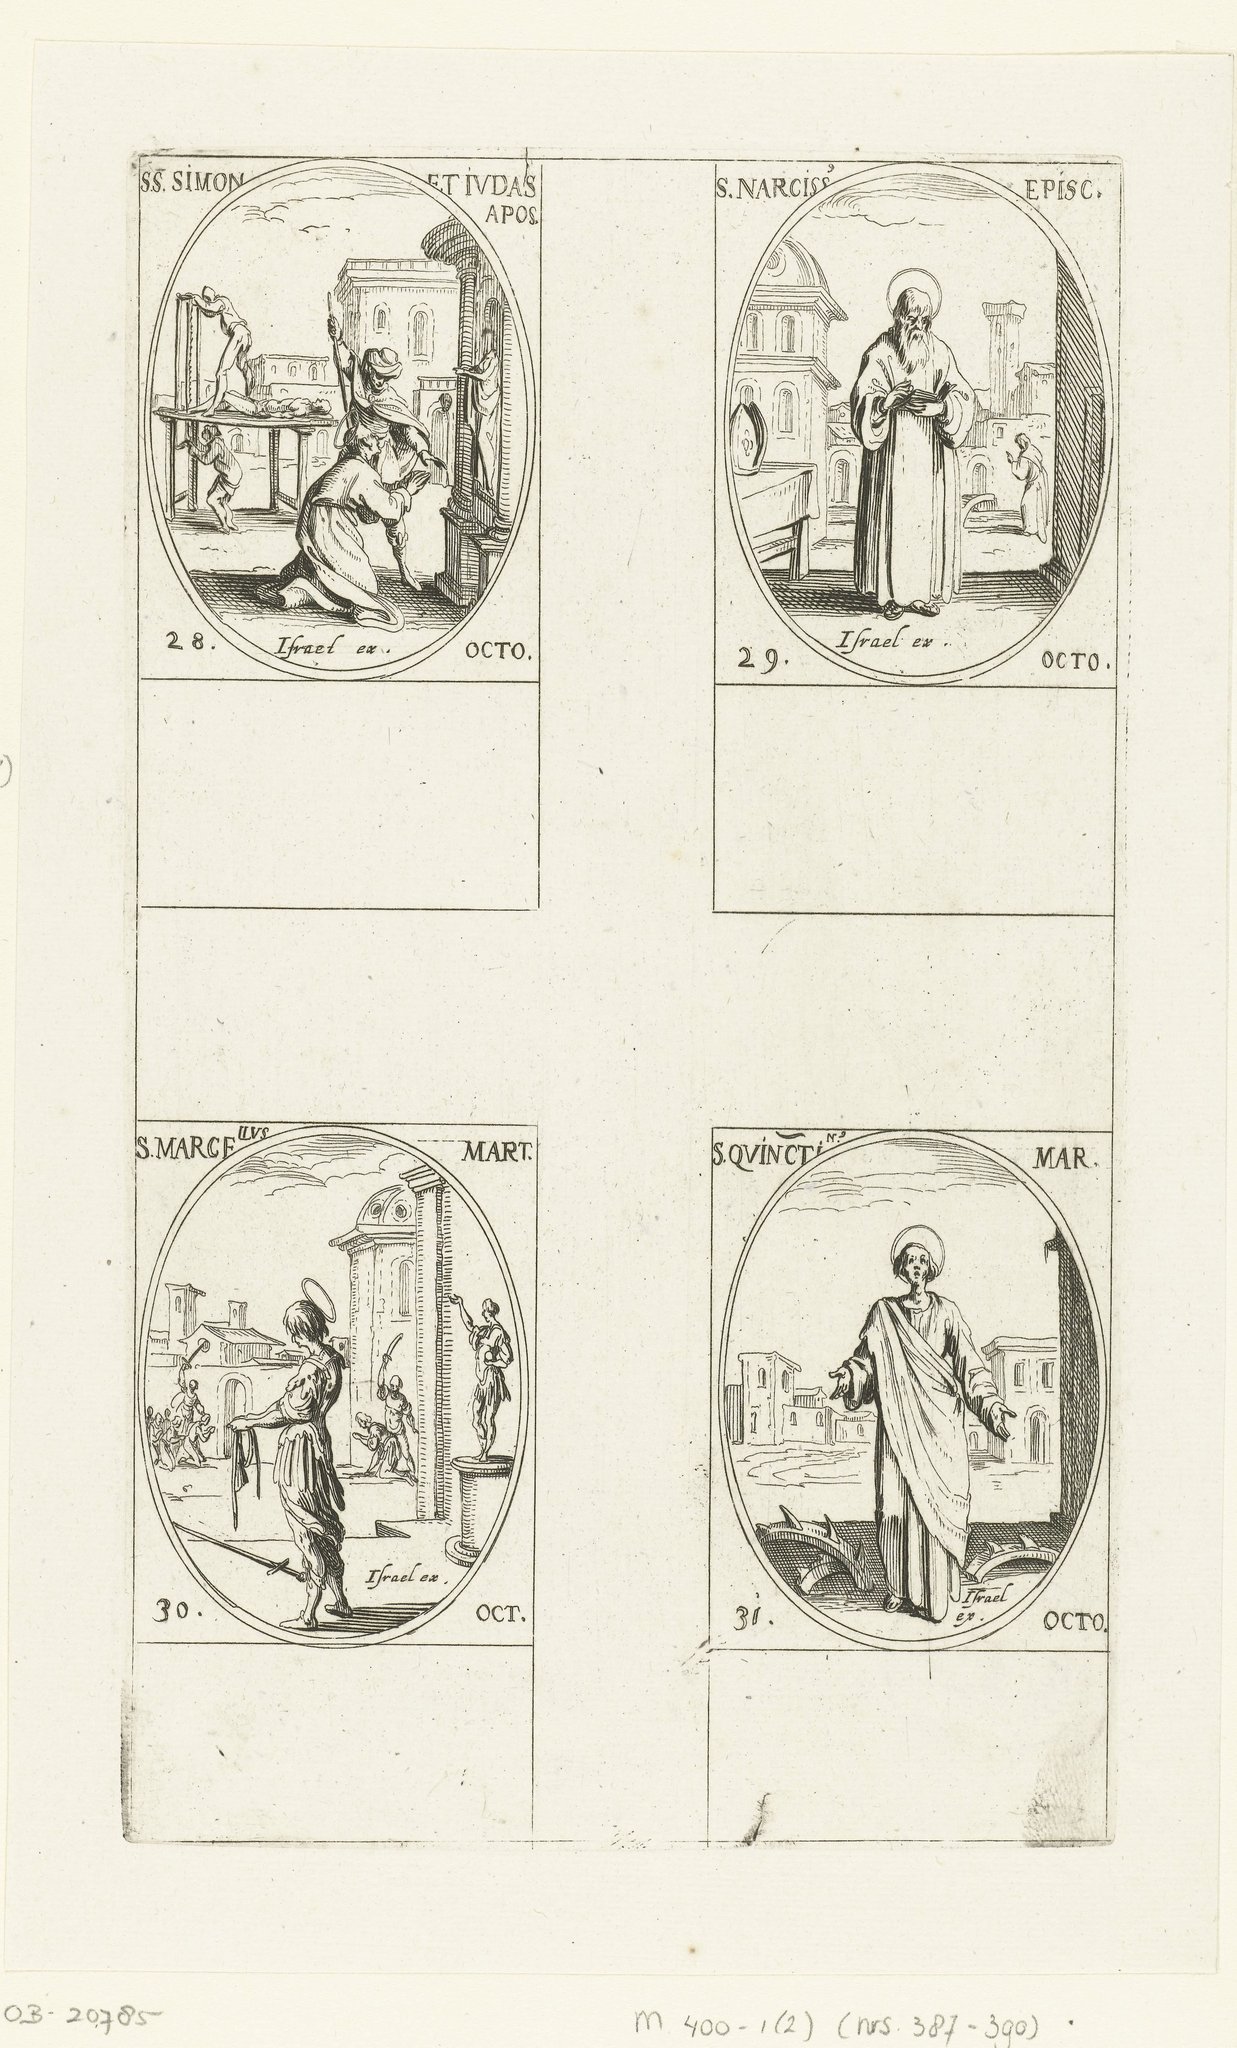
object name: print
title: Heilige Simon de Zeloot en Heilige Judas Taddeüs, Heilige Narcissus van Gerona, Heilige Marcellus van Tanger, Heilige Quintinus van Saint-Quentin (28-31 oktober)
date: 1632-1636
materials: paper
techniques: etching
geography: nancy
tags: the apostle jude thaddaeus; possible attributes: book, club, halberd, scroll, the apostle simon zelotes (or simon the canaanite); possible attributes: book, saw, scroll, martyrdom and death of simon zelotes: he is sawn in two, or beaten to death, martyrdom and death of judas thaddaeus: he is beaten to death and beheaded, the martyr quintin(us) (quentin) of vermand; possible attributes: nail(s), male saints (with name)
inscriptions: collector's mark: Lugt 240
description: Blad met vier ovale voorstellingen, elk met opschrift en datum in het Latijn: linksboven de apostelen Simon de Zeloot en Judas Taddeüs die gemarteld worden met respectievelijk een zaag en een knuppel, rechtsboven de Heilige Narcissus van Gerona staand naast een tafel waarop een mijter ligt, linksonder de Heilige Marcellus van Tanger die zijn wapens aflegt, rechtsonder de Heilige Quintinus van Saint-Quentin bij een gebroken wiel met weerhaken. Deze prent is onderdeel van een serie prenten met voorstellingen van de heiligen en de christelijke feestdagen van het jaar. Er zijn steeds vier scènes van één plaat op één blad gedrukt. Inclusief bijbehorend titelblad en frontispice gaat het in totaal om 124 platen (490 voorstellingen). De drie platen met de laatste 12 scènes (de veranderlijke christelijke feestdagen) zijn in de derde staat versneden tot 12 kleine plaatjes, en met een apart titelblad uitgegeven.